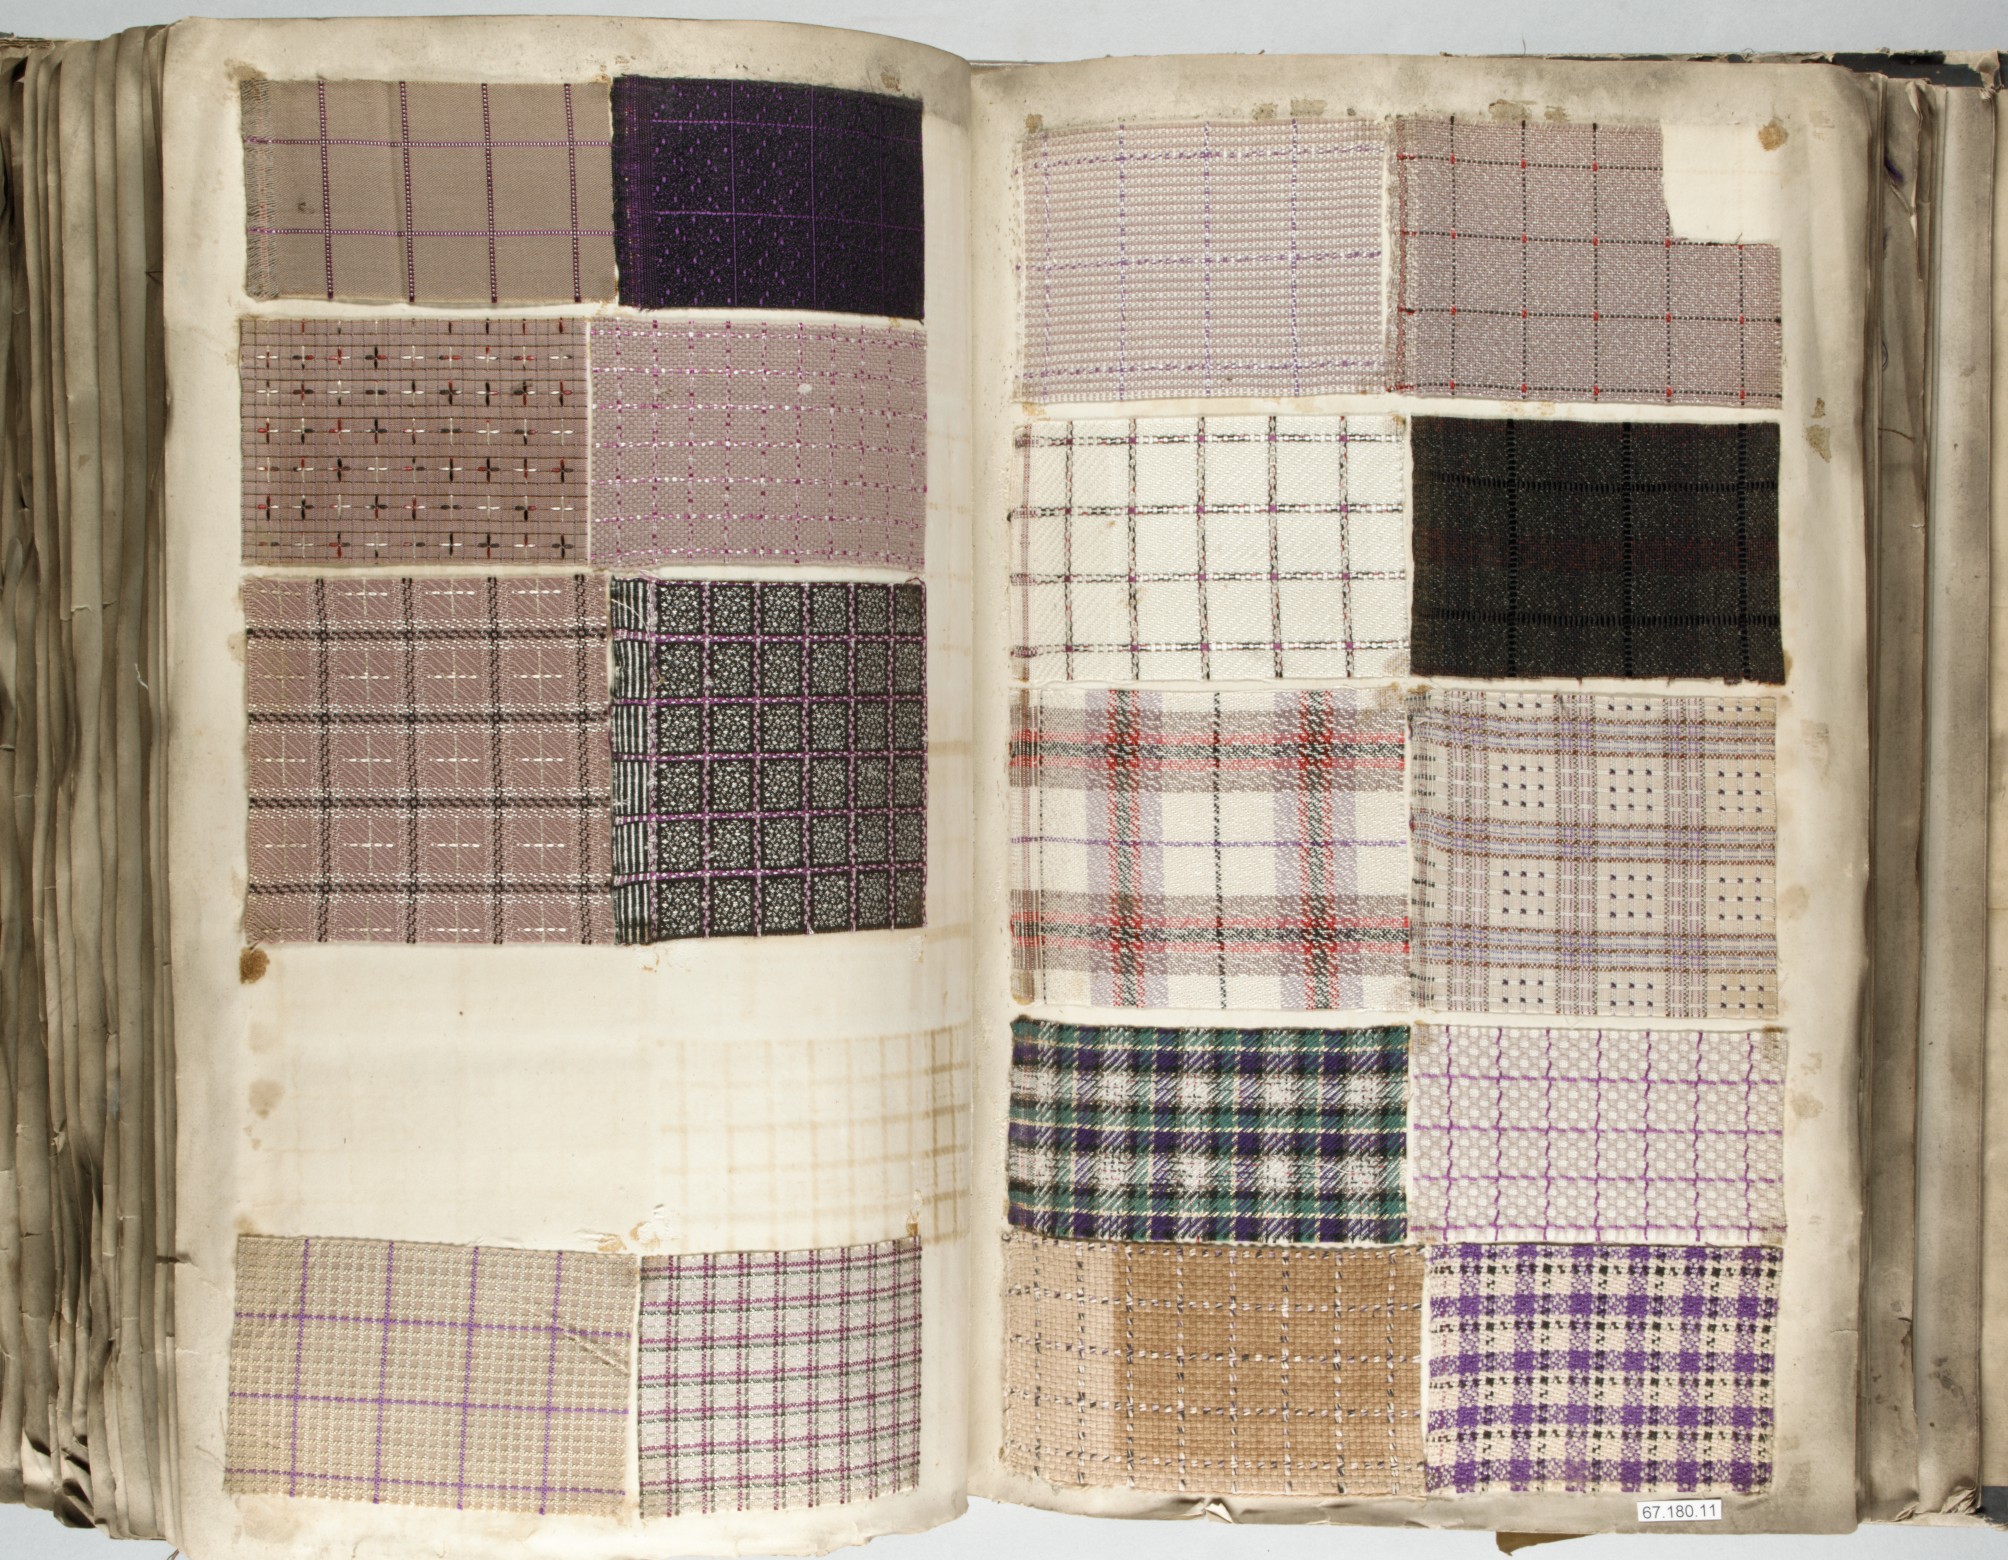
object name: sample book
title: Textile Sample Book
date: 1862